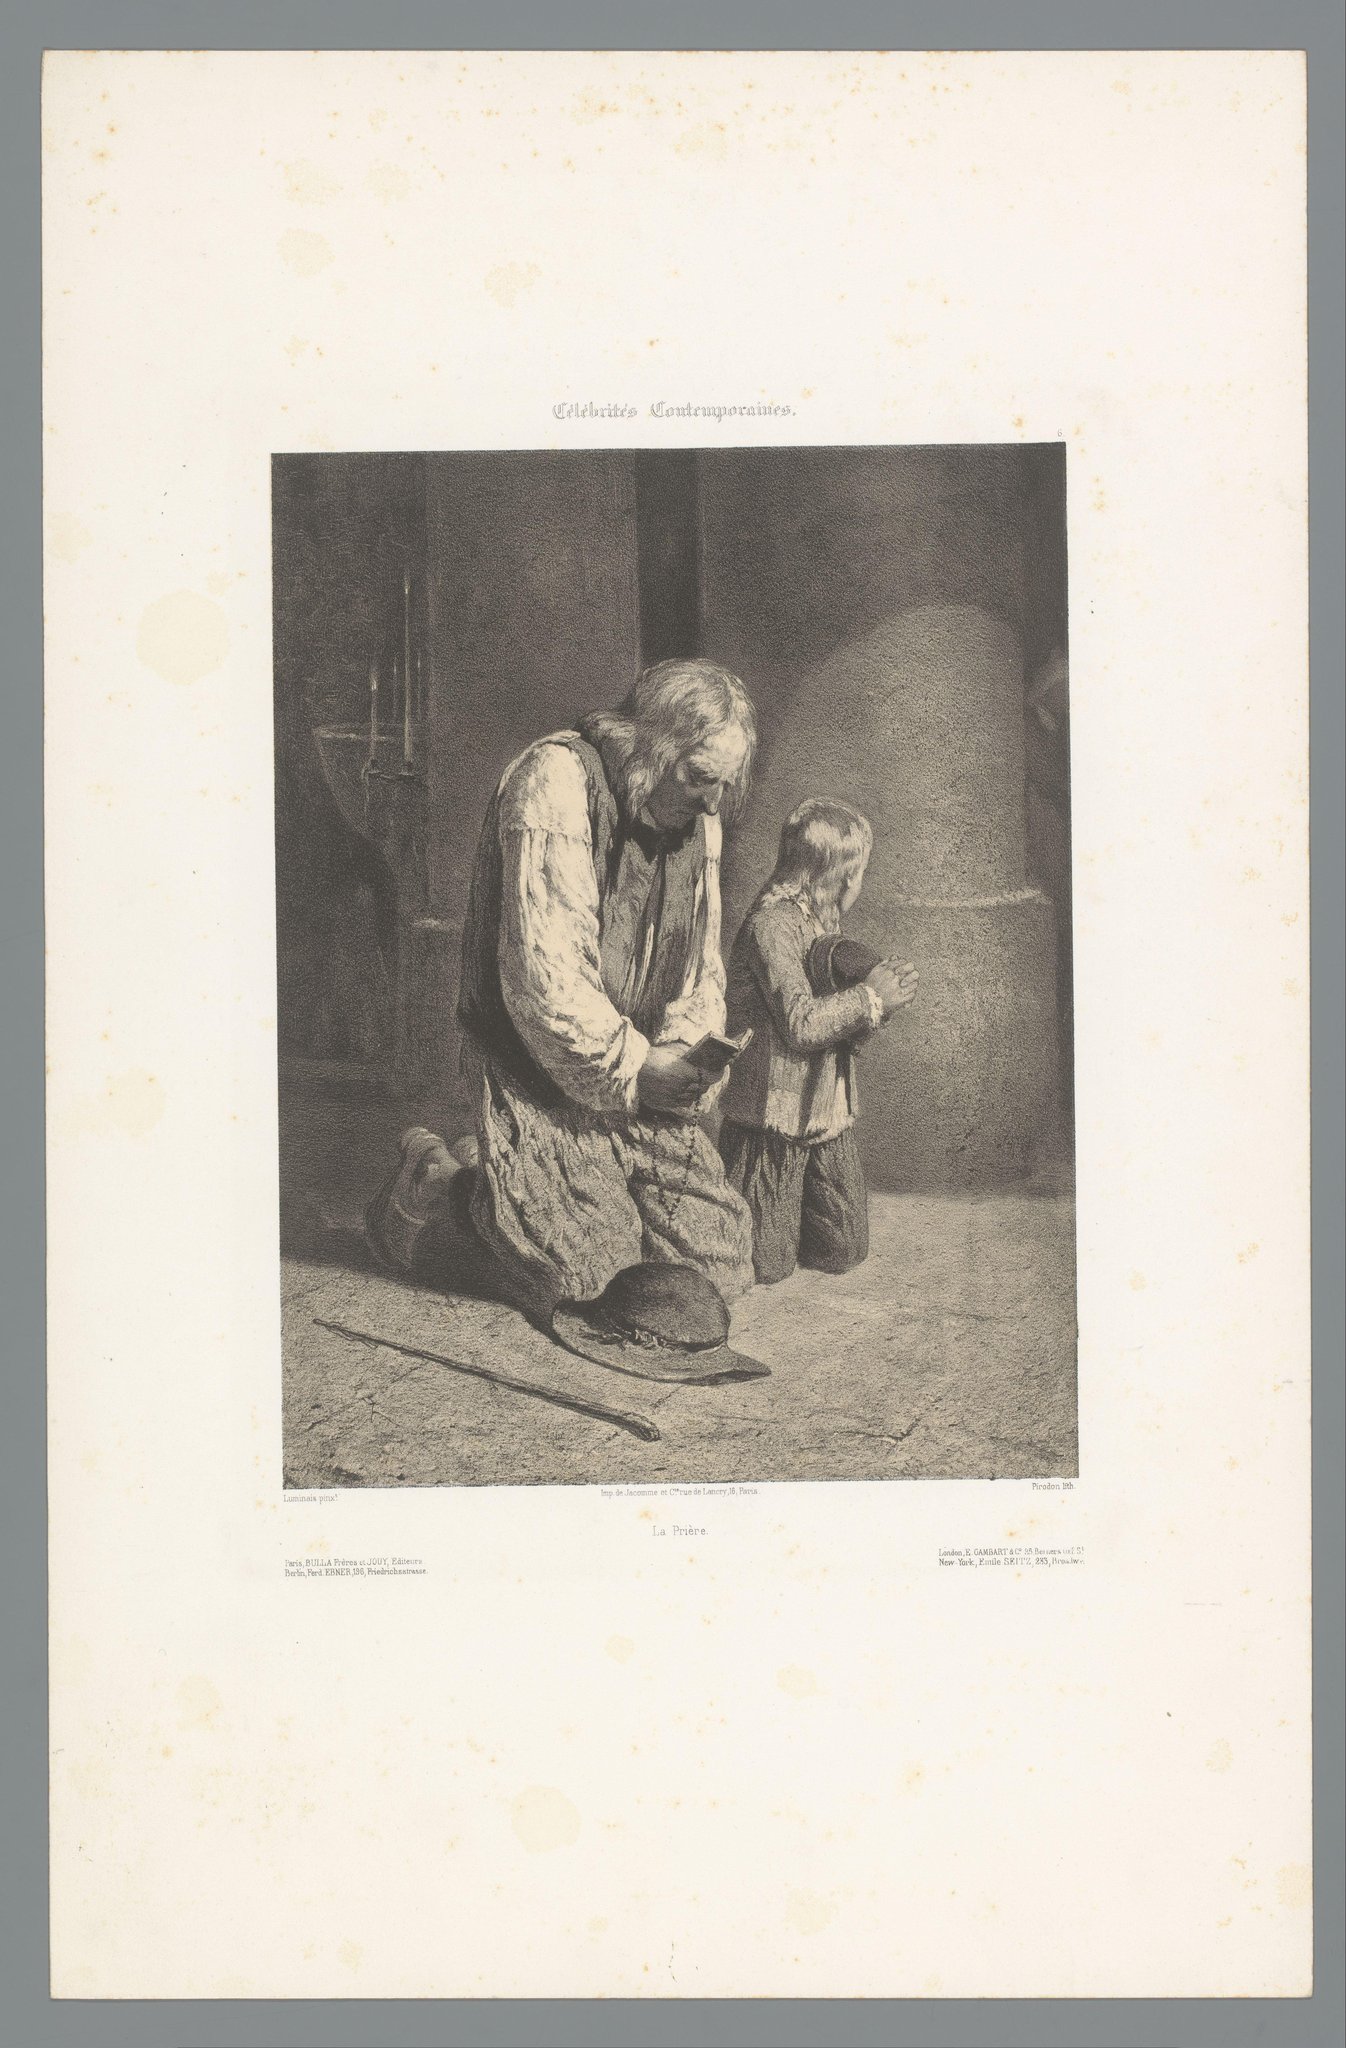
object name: print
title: Man en kind bidden geknield in een kerk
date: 1853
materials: paper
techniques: tone lithography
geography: paris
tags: adult man, child, (private) prayer; 'oratione', 'preghiere', 'preghiere a dio' (ripa)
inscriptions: collector's mark: Lugt 2228